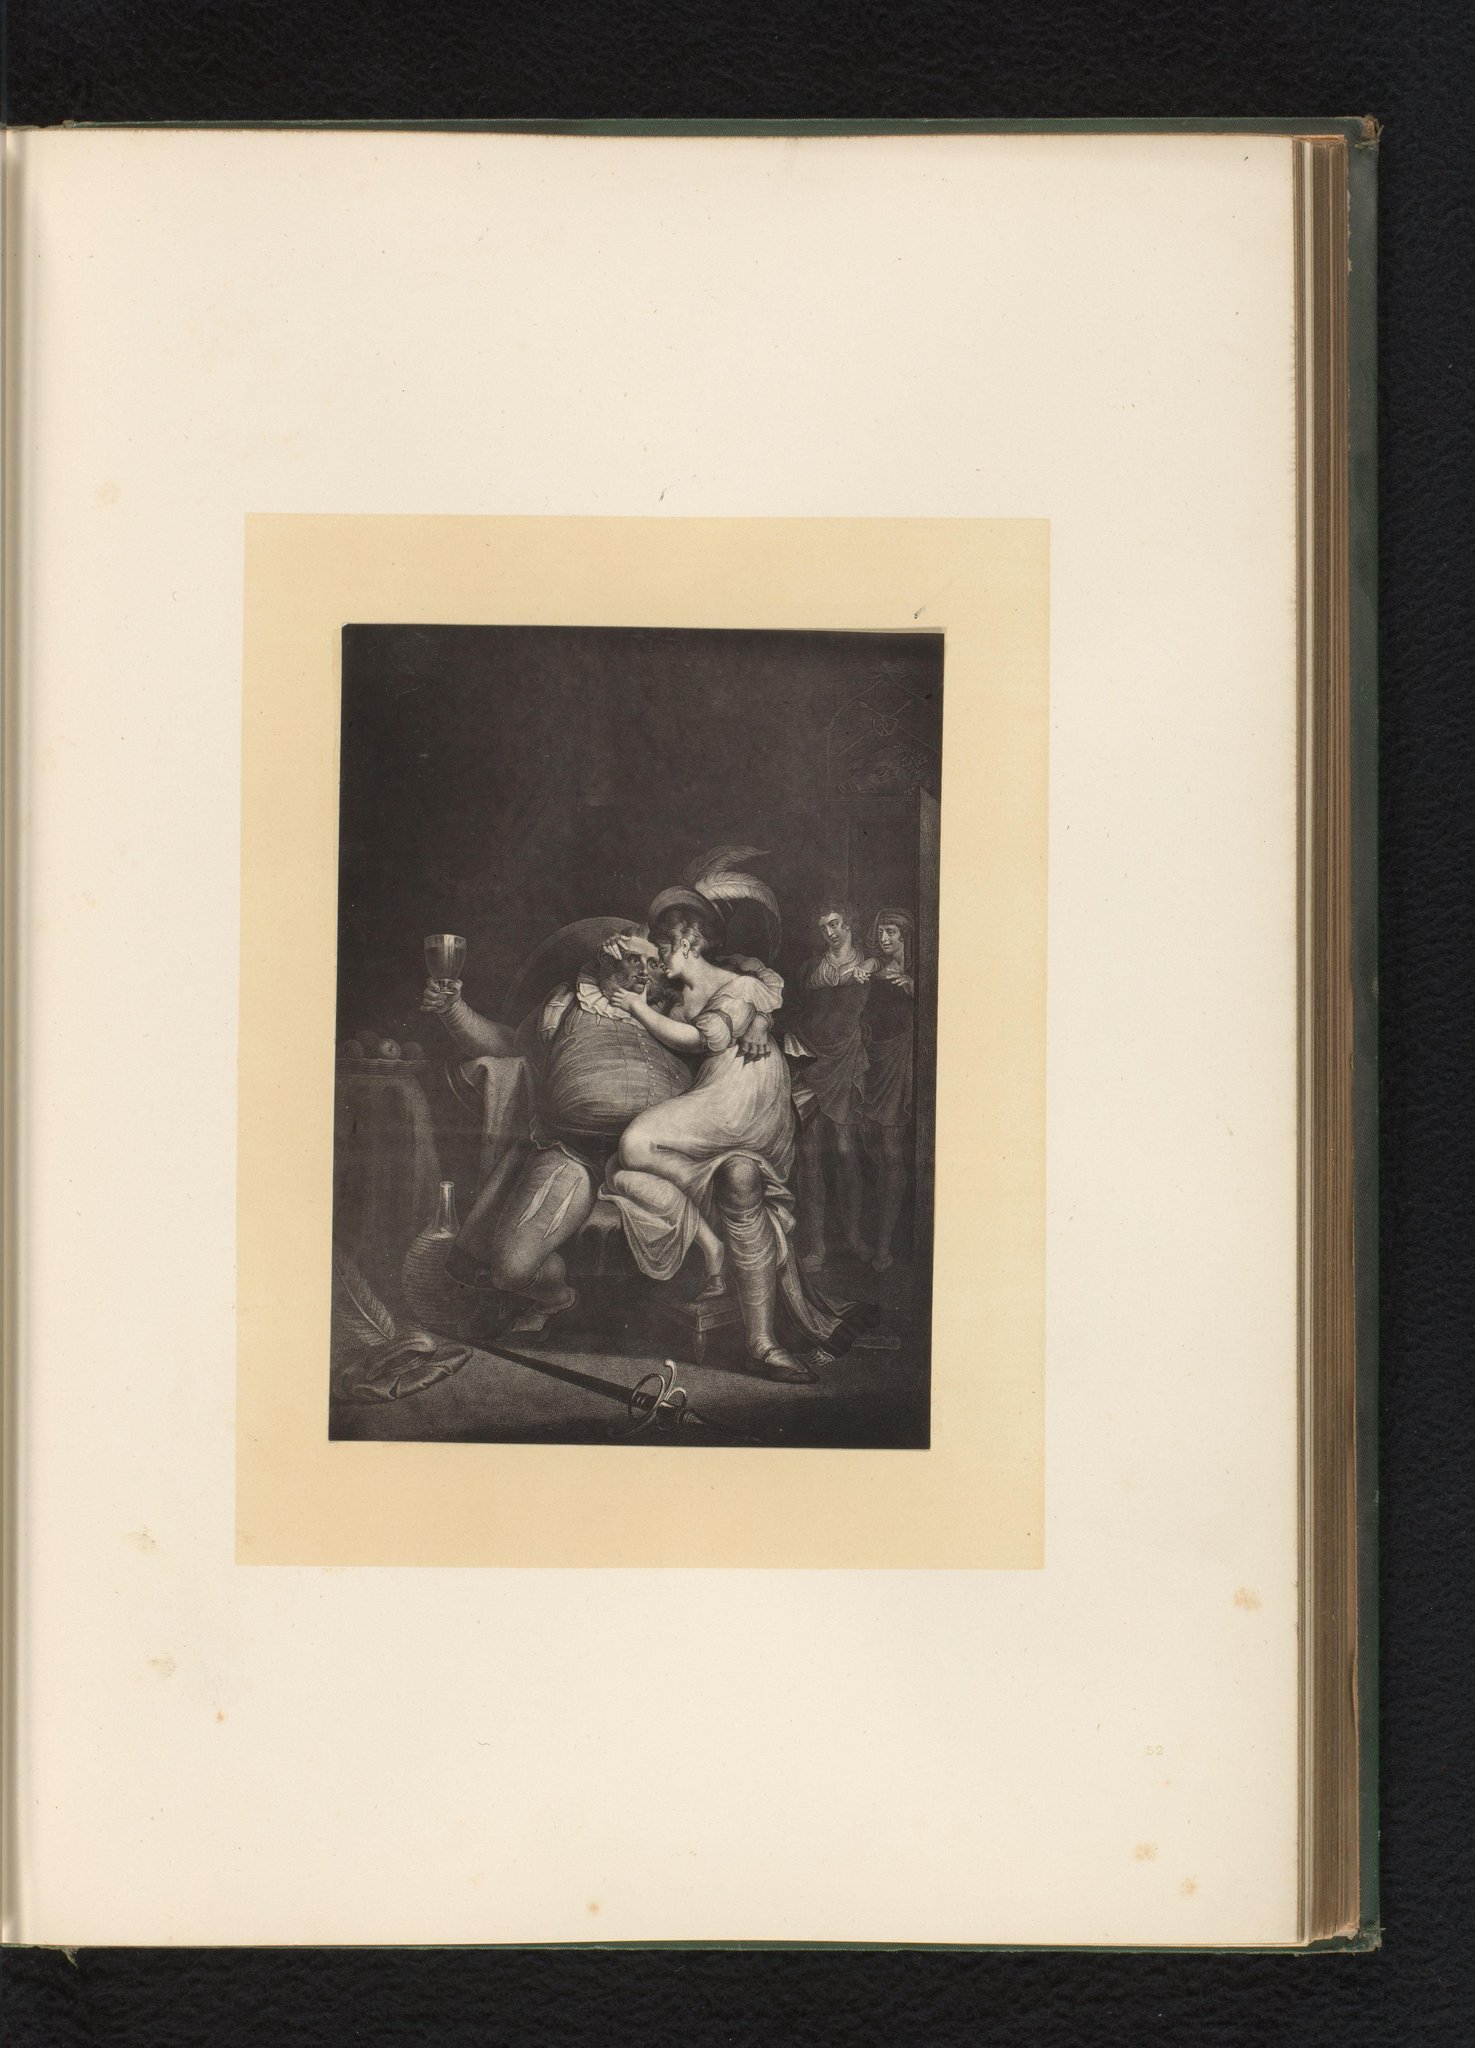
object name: reproduction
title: King Henry the Fourth, Act II, Scene 4: A Room in the Boar's-Head Tavern, in Eastcheap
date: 1874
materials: paper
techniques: woodburytype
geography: london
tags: theatre, theatrical performance